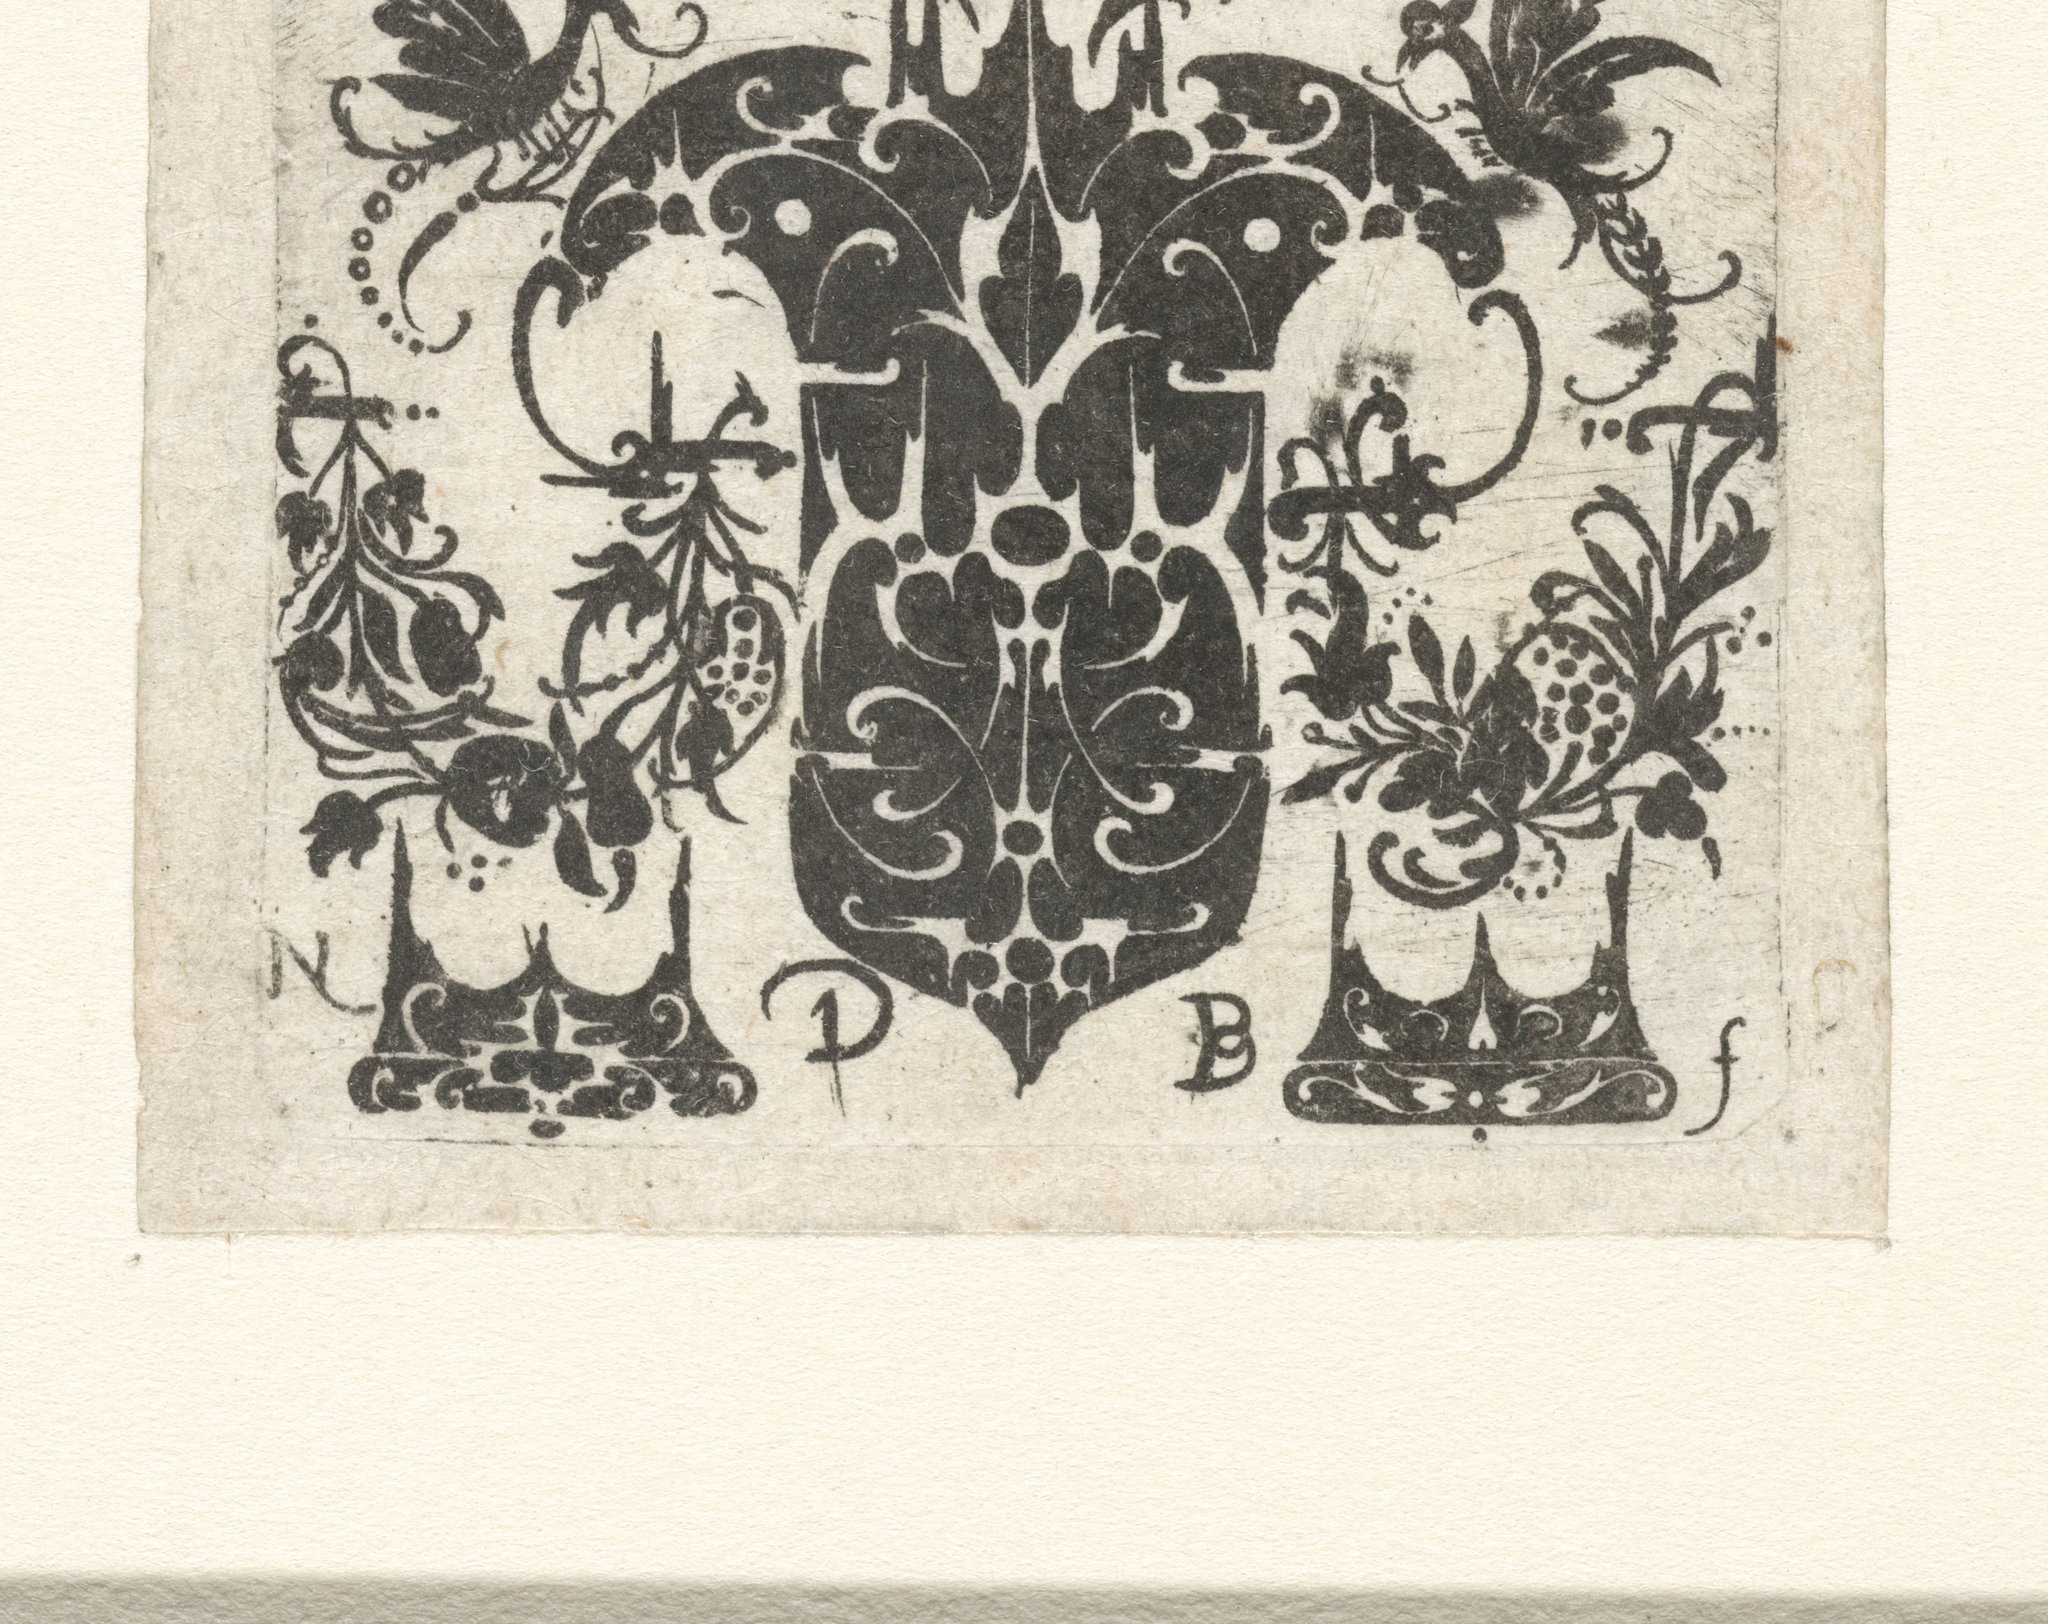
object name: ornament print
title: Ontwerpen voor goudsmeden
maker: Anonymous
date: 1500-1600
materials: paper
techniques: etching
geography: netherlands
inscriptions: inscription: ‘H. de Bull’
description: Aan het ornament hangt aan weerszijden een guirlande. Linksonder en rechtsonder een kleiner ornament. Een van vier bladen met kleine ornamenten, gedecoreerd met arabesken en geometrische motieven. De decoraties zijn wit op een zwart fond.